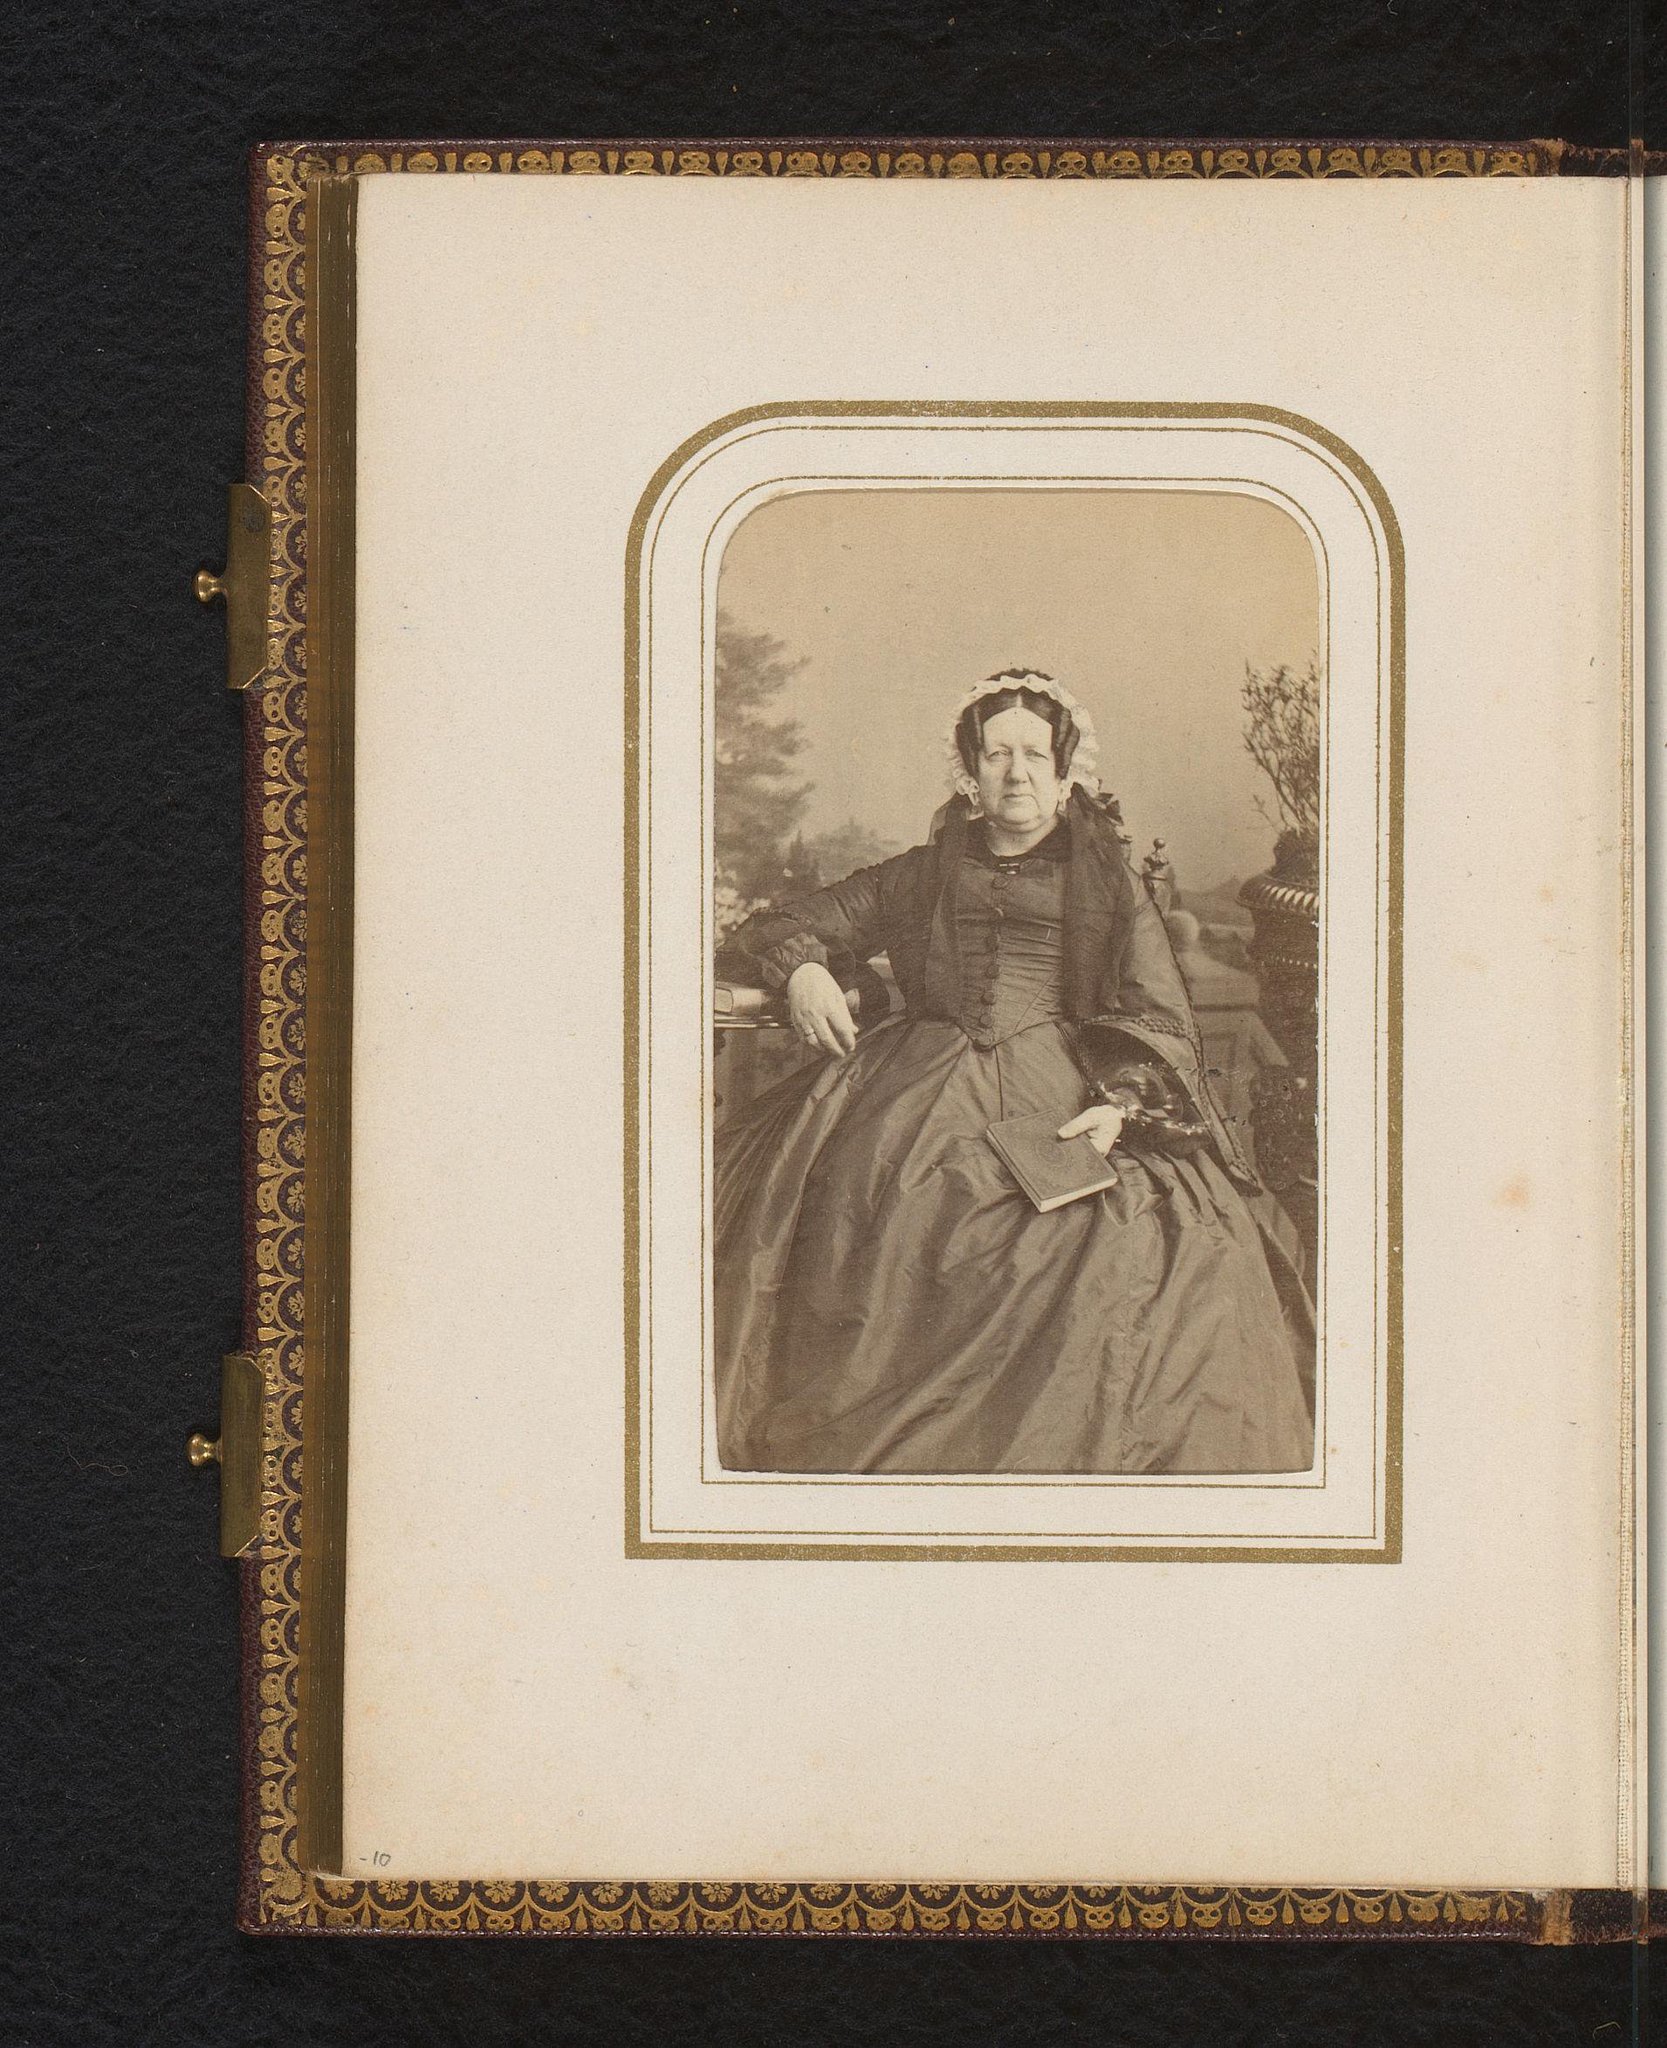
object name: photograph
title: Portret van een onbekende vrouw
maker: henri pronk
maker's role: fotograaf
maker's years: 1813-1893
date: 1864-1867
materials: cardboard, paper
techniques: albumen print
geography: the hague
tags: anonymous historical person portrayed - bb - woman